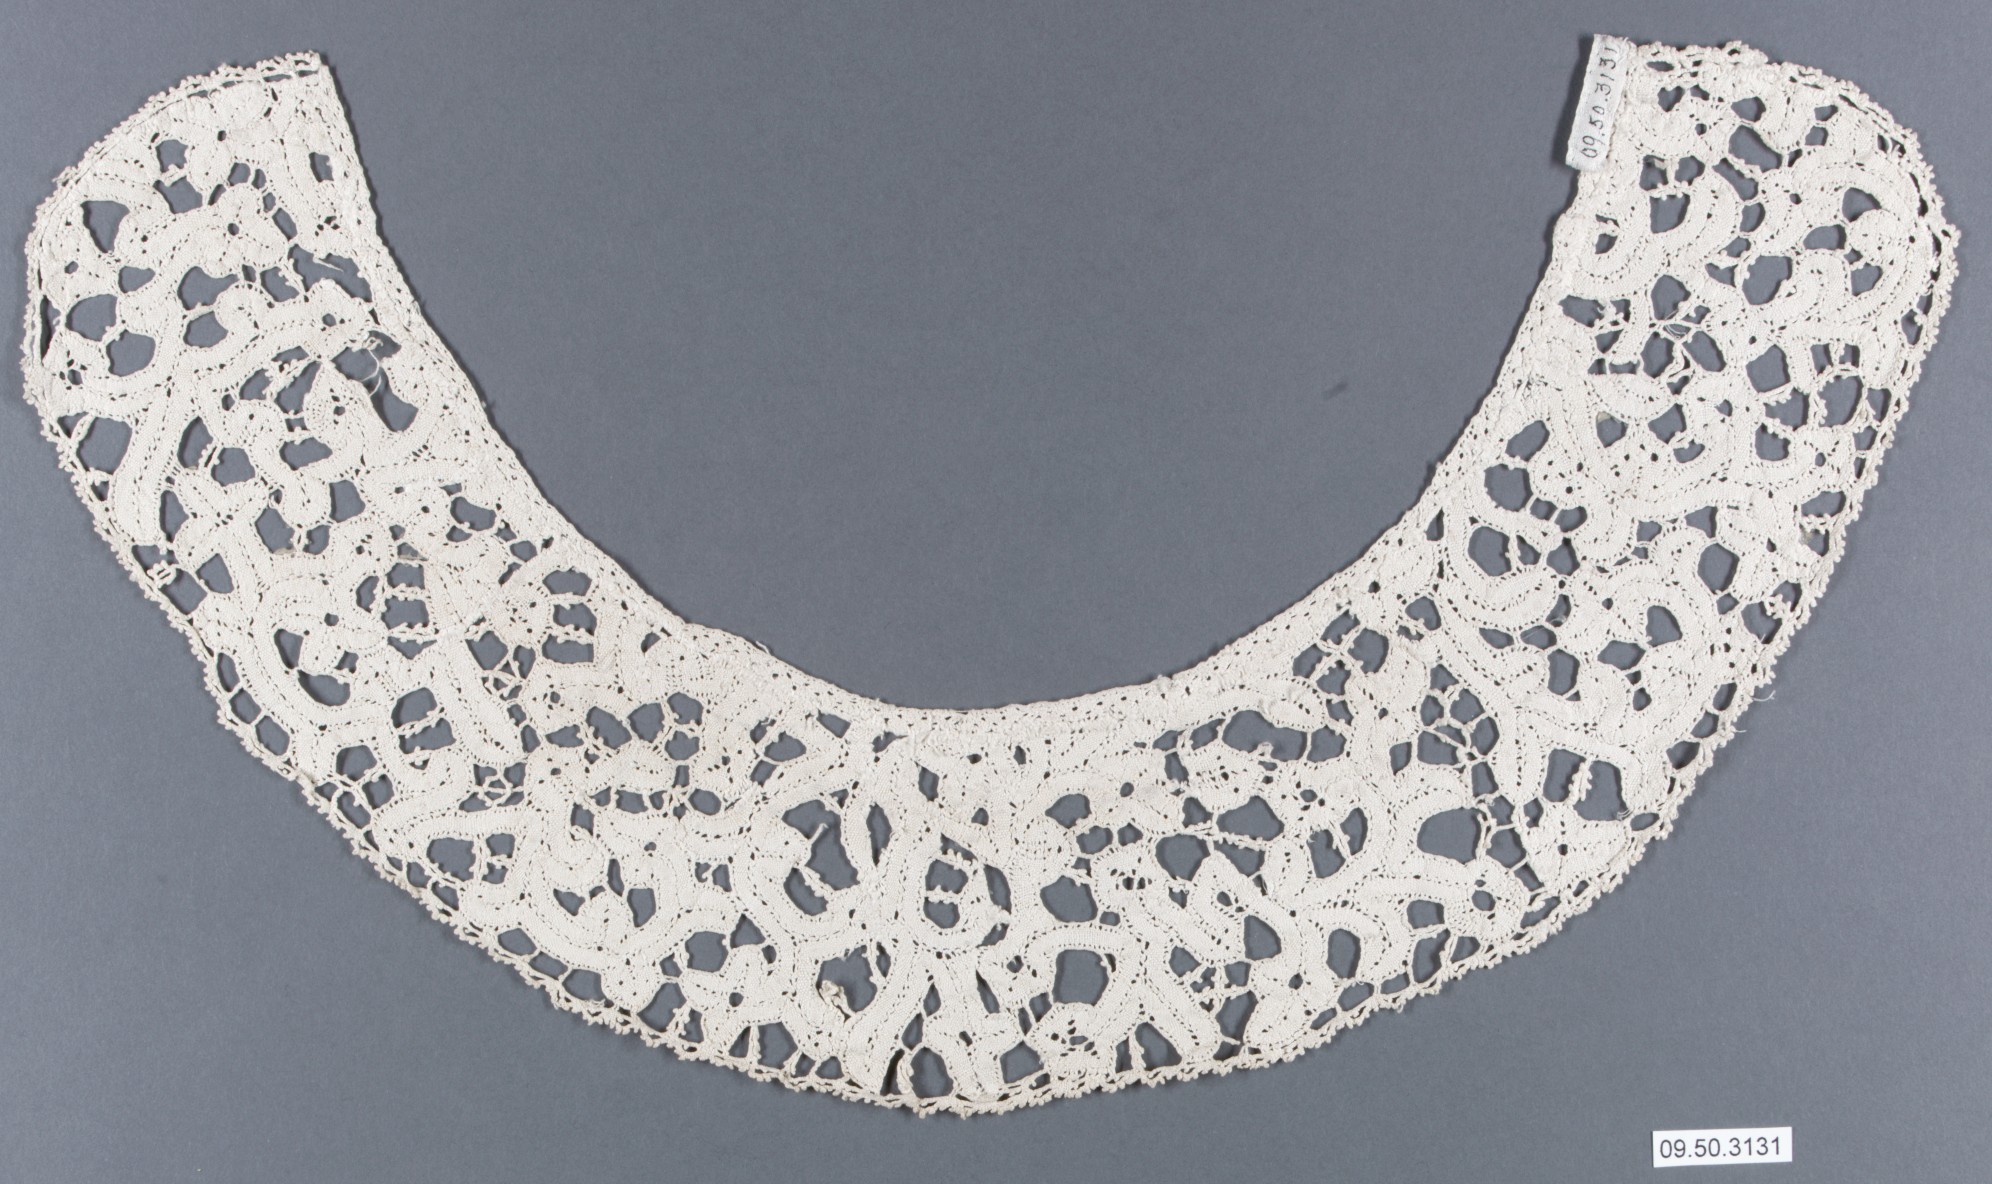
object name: collar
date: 1701-1800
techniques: lace